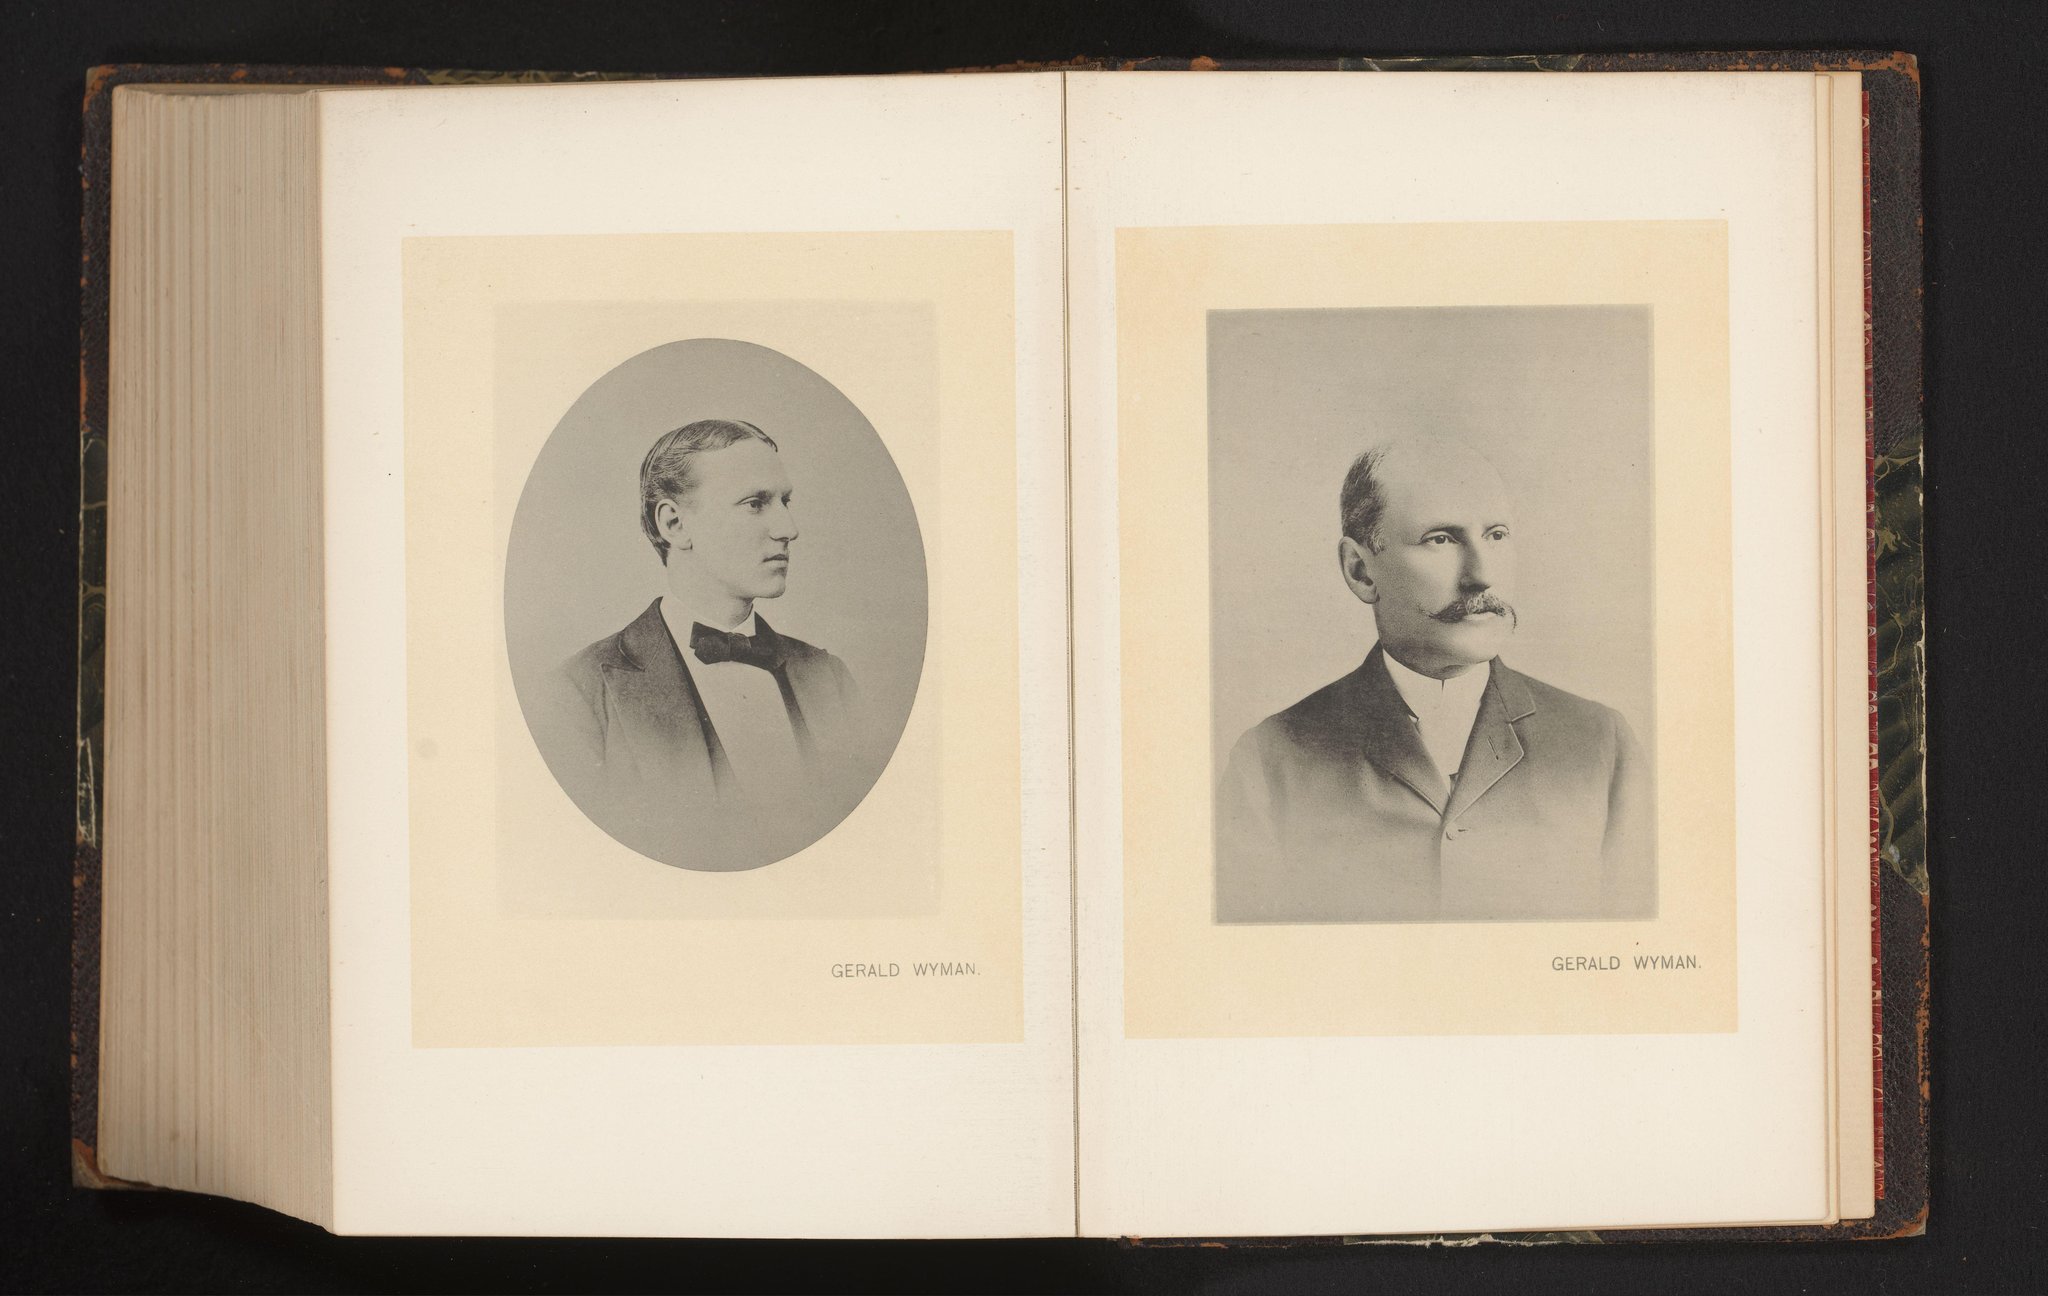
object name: page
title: Gerald Wyman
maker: Anonymous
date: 1889-1894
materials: paper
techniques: photoaquatint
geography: boston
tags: adult man